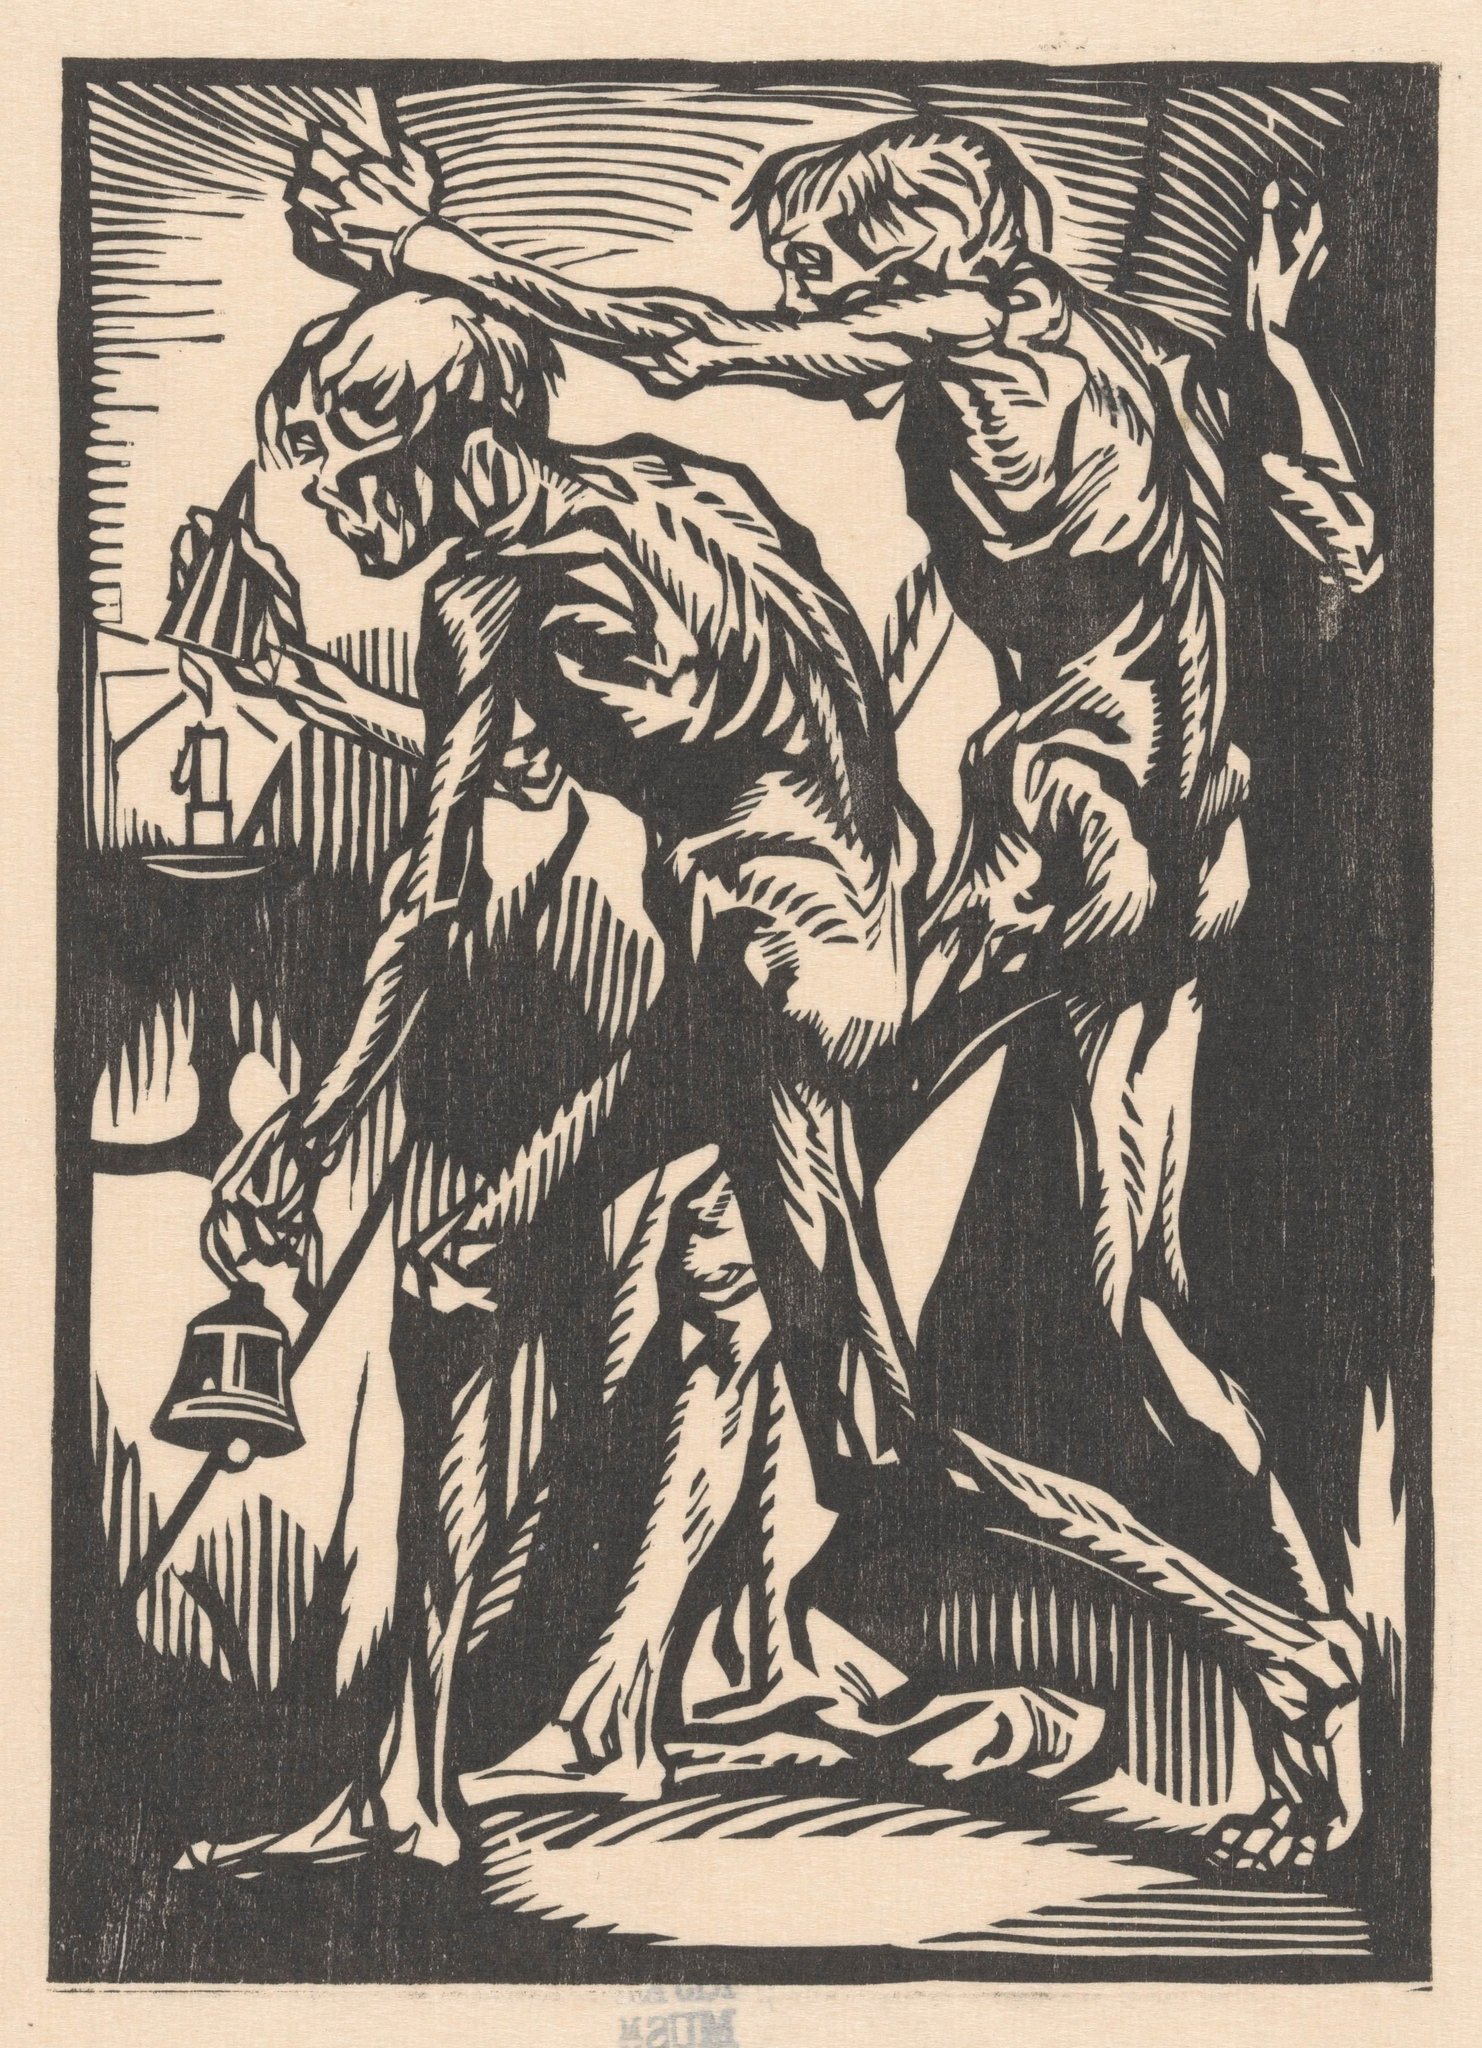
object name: print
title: Twee naakte mannenfiguren met bel en kaarsendover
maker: johannes josephus aarts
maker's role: draughtsman, print maker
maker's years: 1871-1934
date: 1881-1934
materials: paper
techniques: woodcut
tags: (showing oneself) undressed, quasi-nude, candle, bell ~ acoustic signalling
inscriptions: collector's mark: Lugt 2760, collector's mark: Lugt 2166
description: Twee naakte, uitgemergelde mannenfiguren lopen in een ruimte. De voorste draagt een bel in zijn linkerhand en dooft een kaars met de kaarsendover in zijn rechterhand.